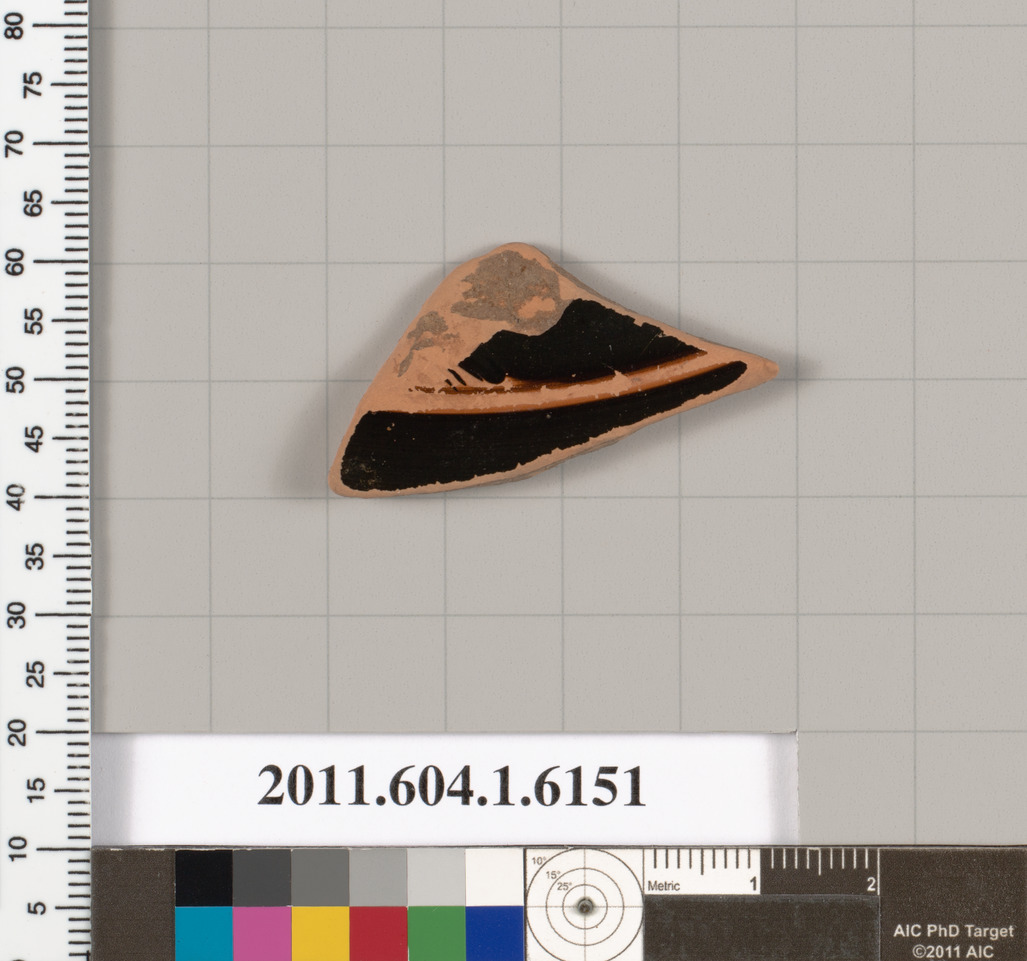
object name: kylix fragment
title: Terracotta fragment of a kylix (drinking cup)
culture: greek, attic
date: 520-500 BCE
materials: terracotta